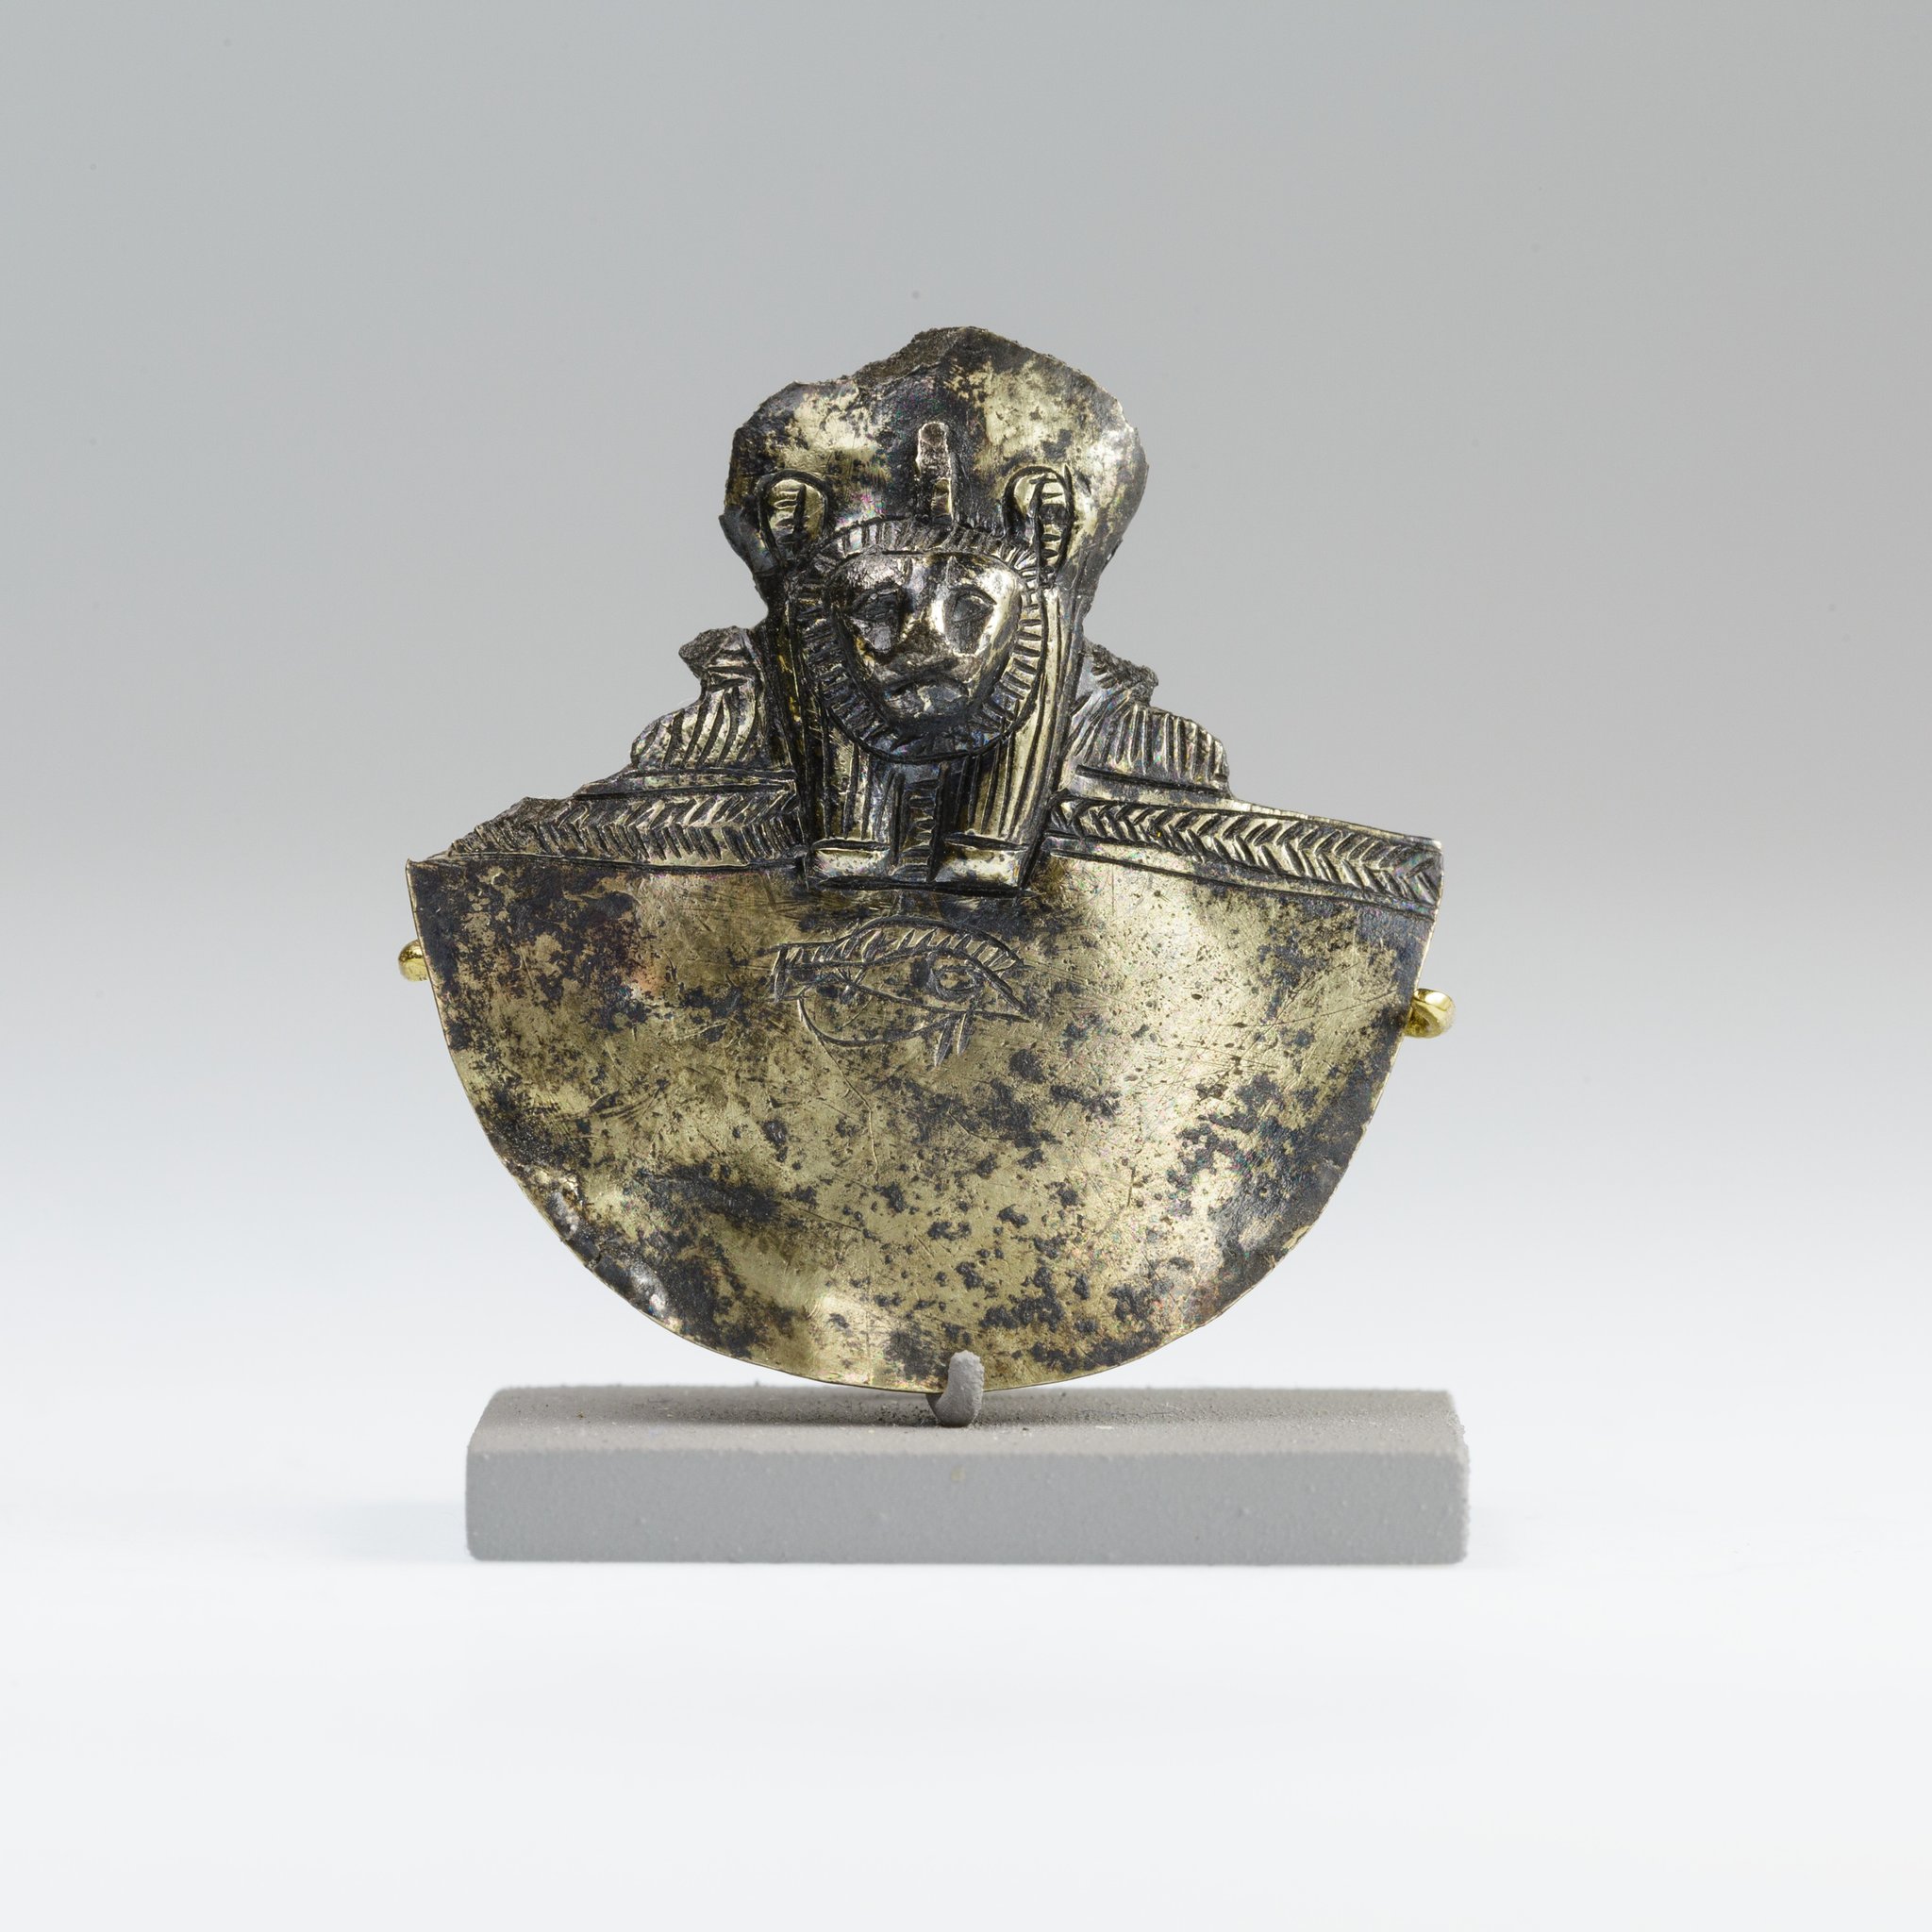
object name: amulet, aegis, bastet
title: Amulet: Head of Sakhmet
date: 664-332 BCE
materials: silver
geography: egypt